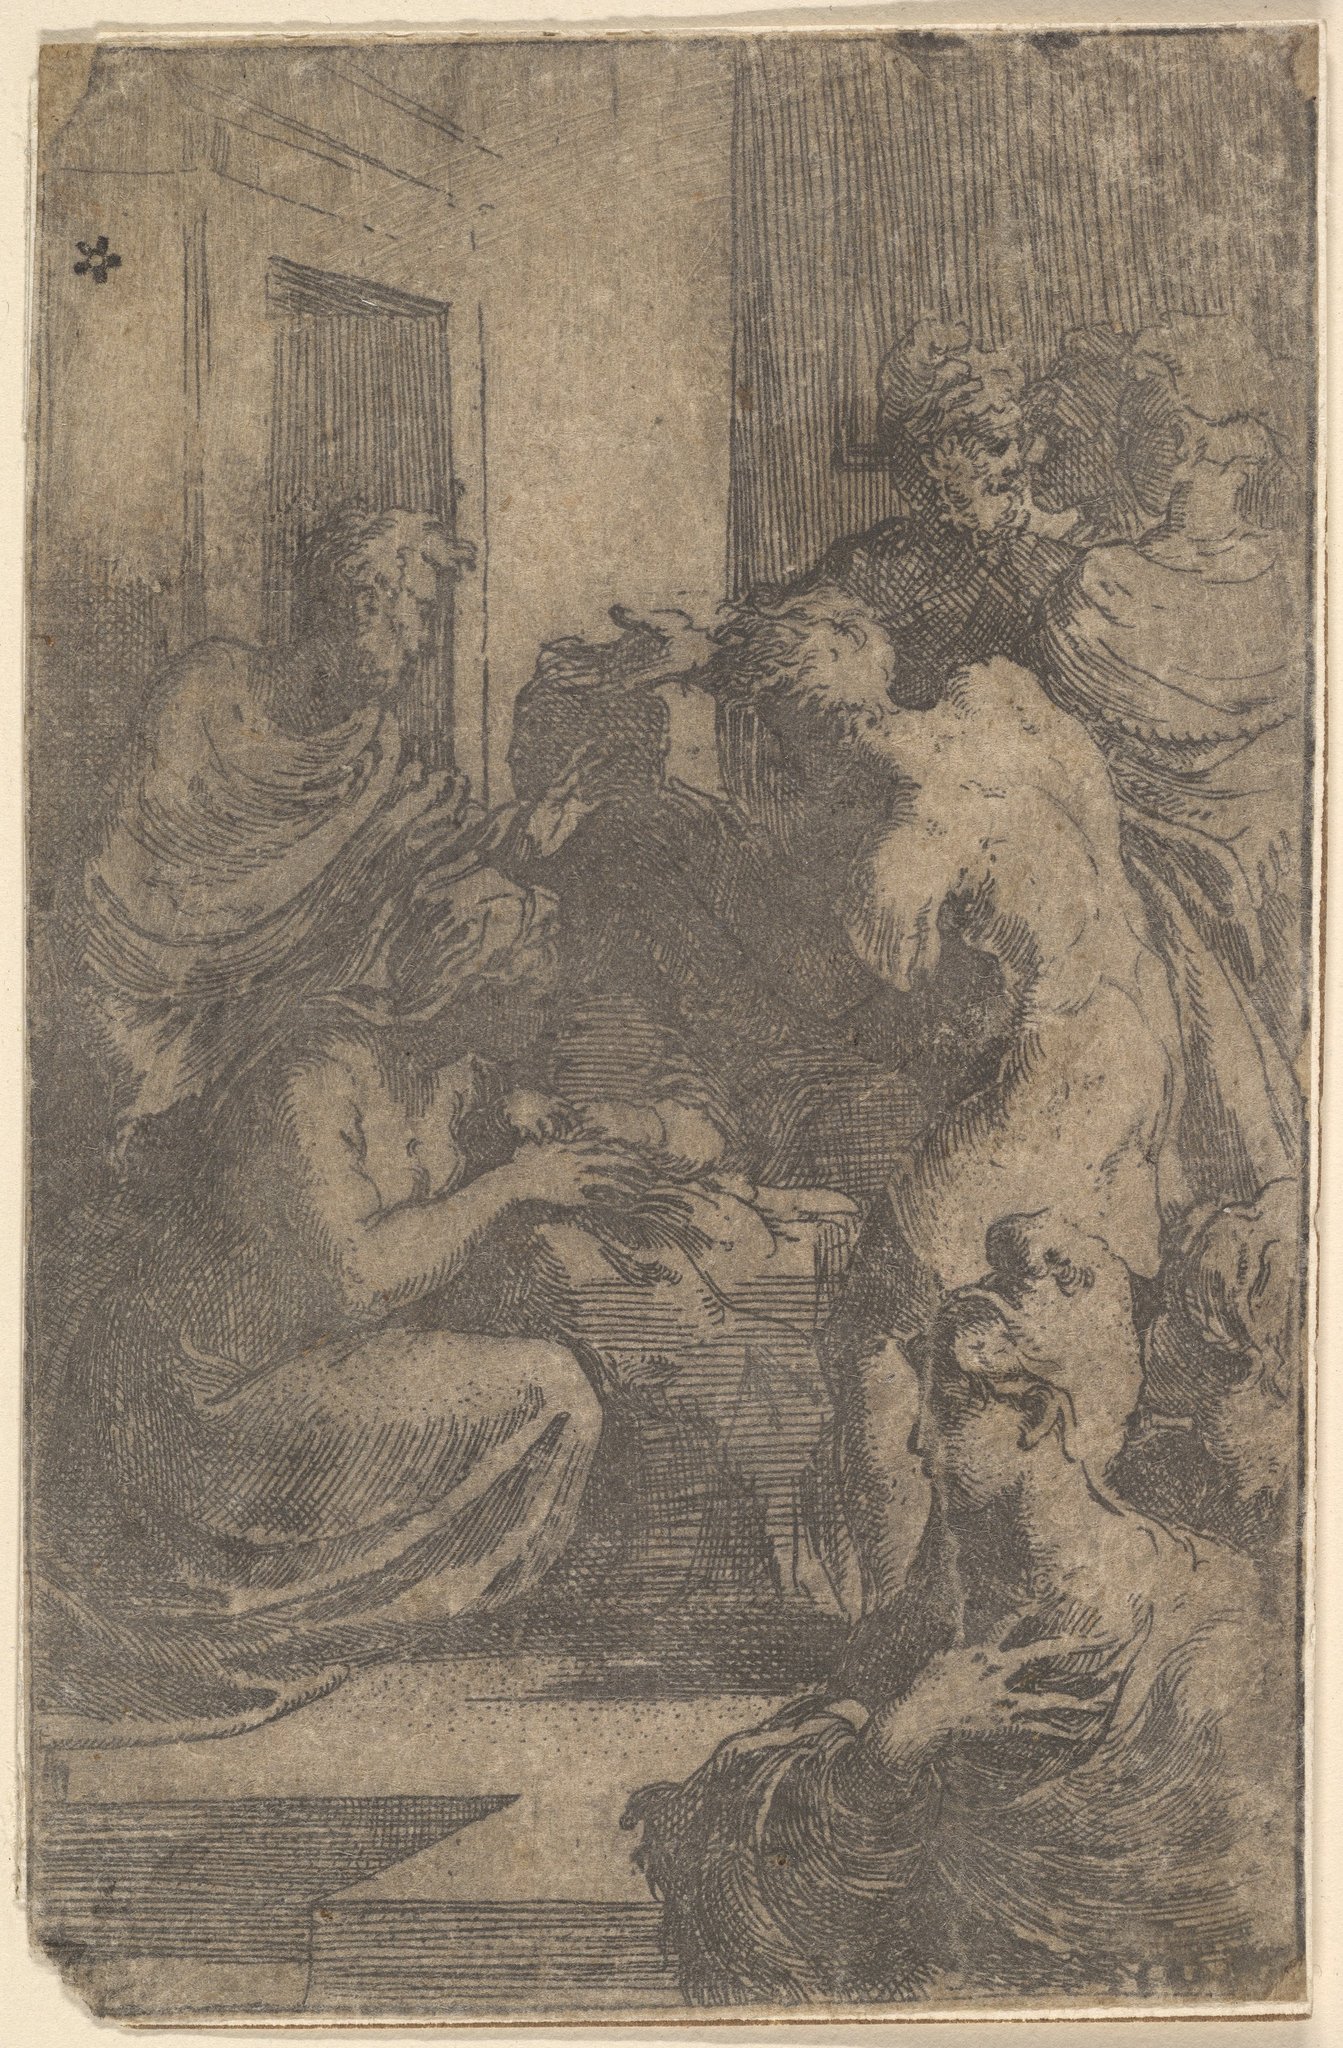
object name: print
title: The Nativity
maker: parmigianino (girolamo francesco maria mazzola)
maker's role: artist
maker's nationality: italian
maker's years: 1503-1540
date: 1527-1530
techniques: etching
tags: human figures,virgin mary,jesus,nativity